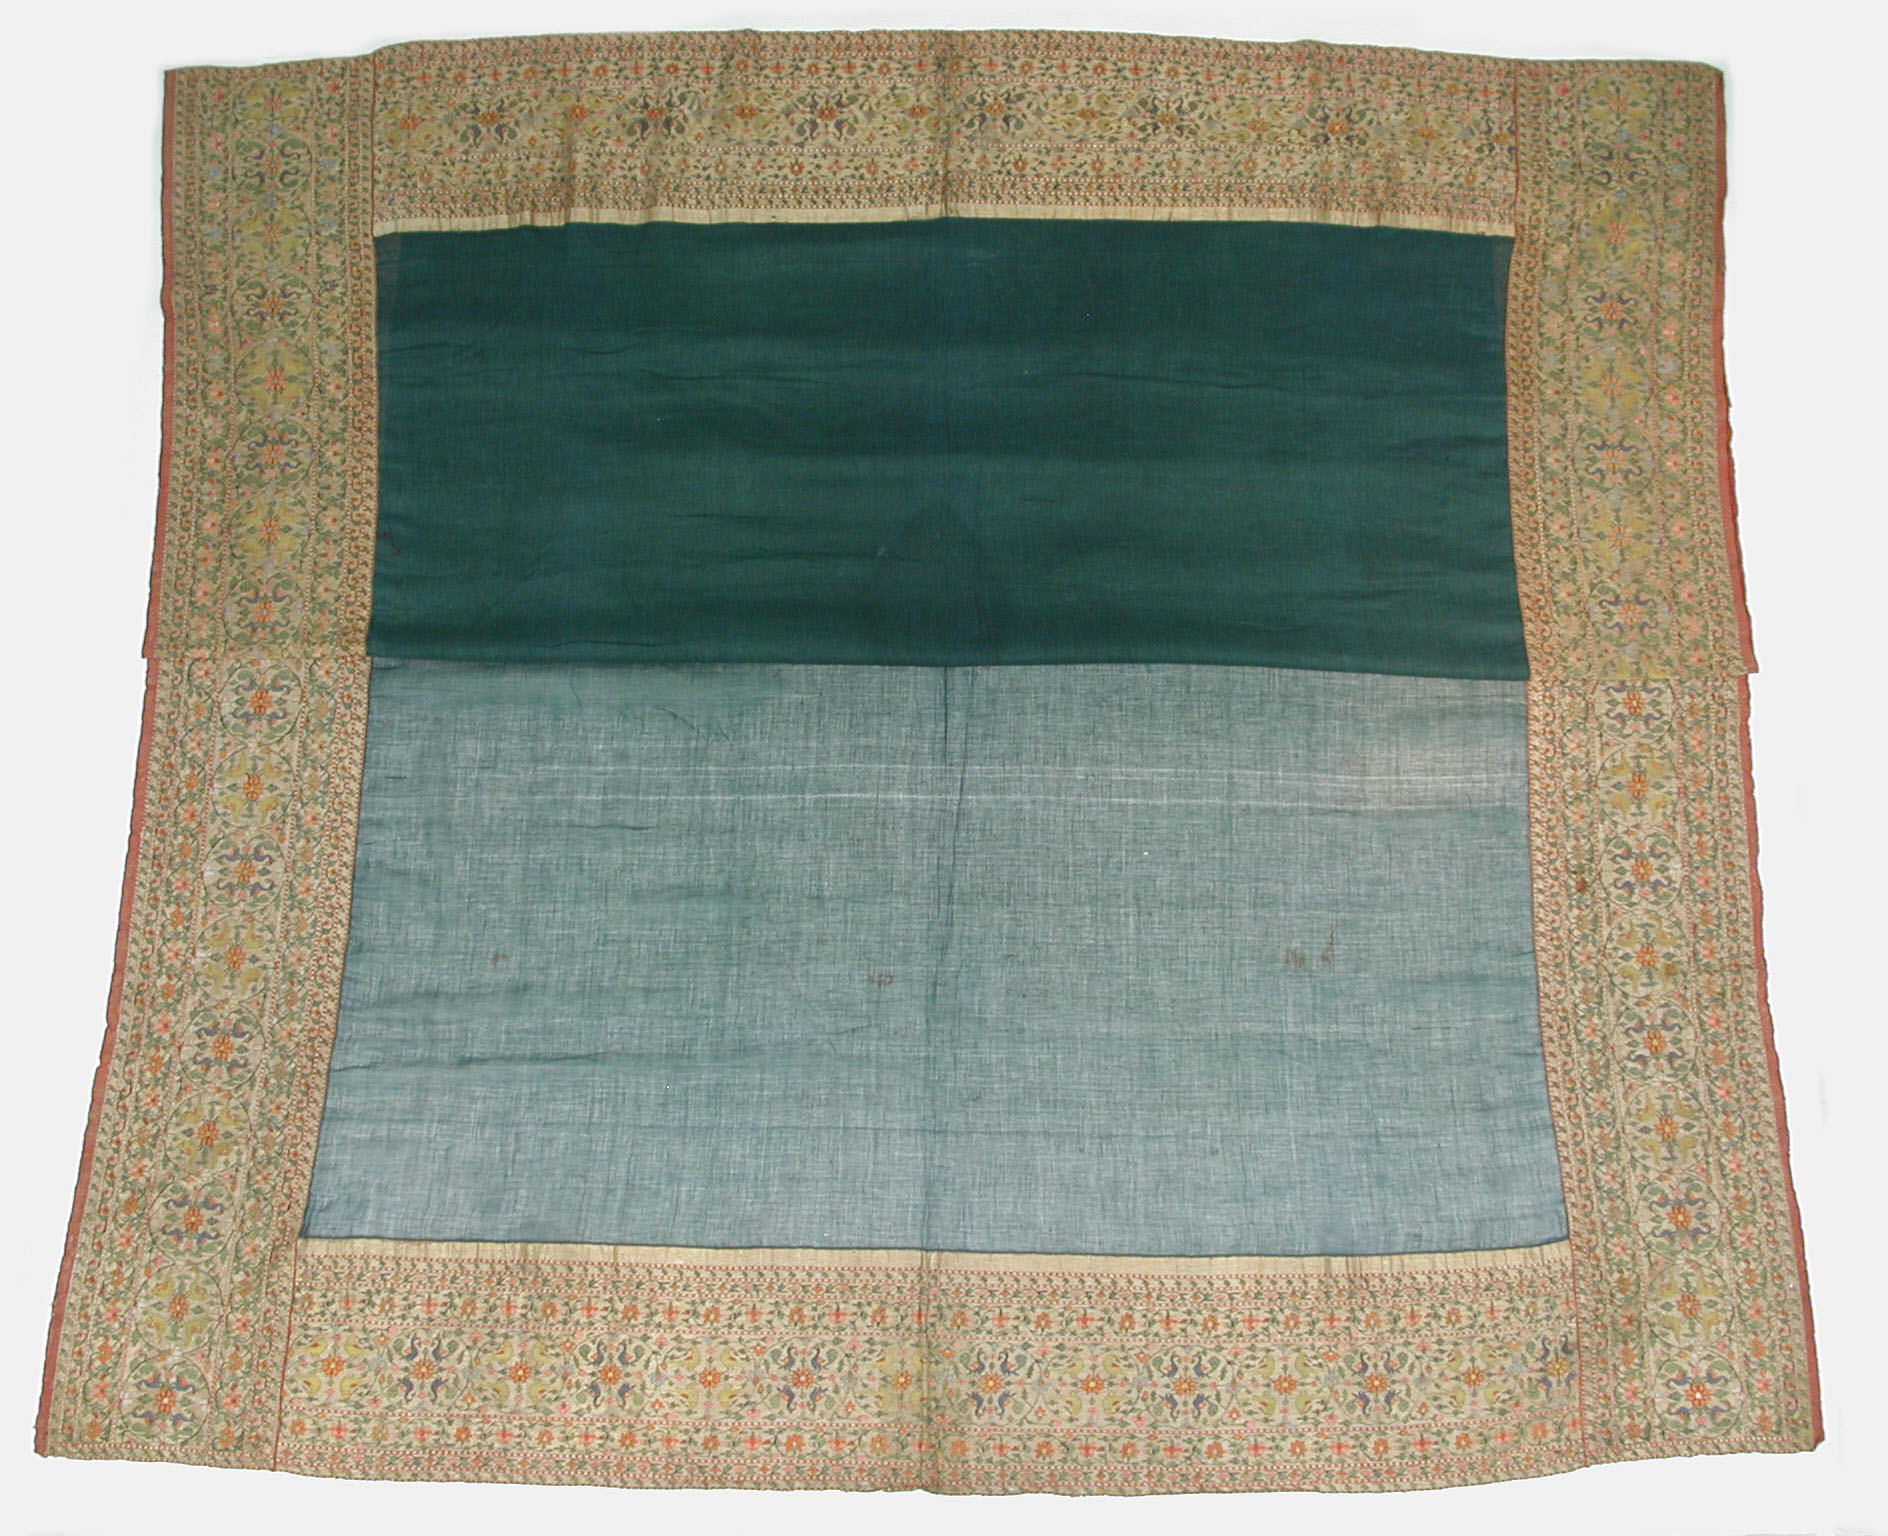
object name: sari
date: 1701-1800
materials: cotton, metal thread, silk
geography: india